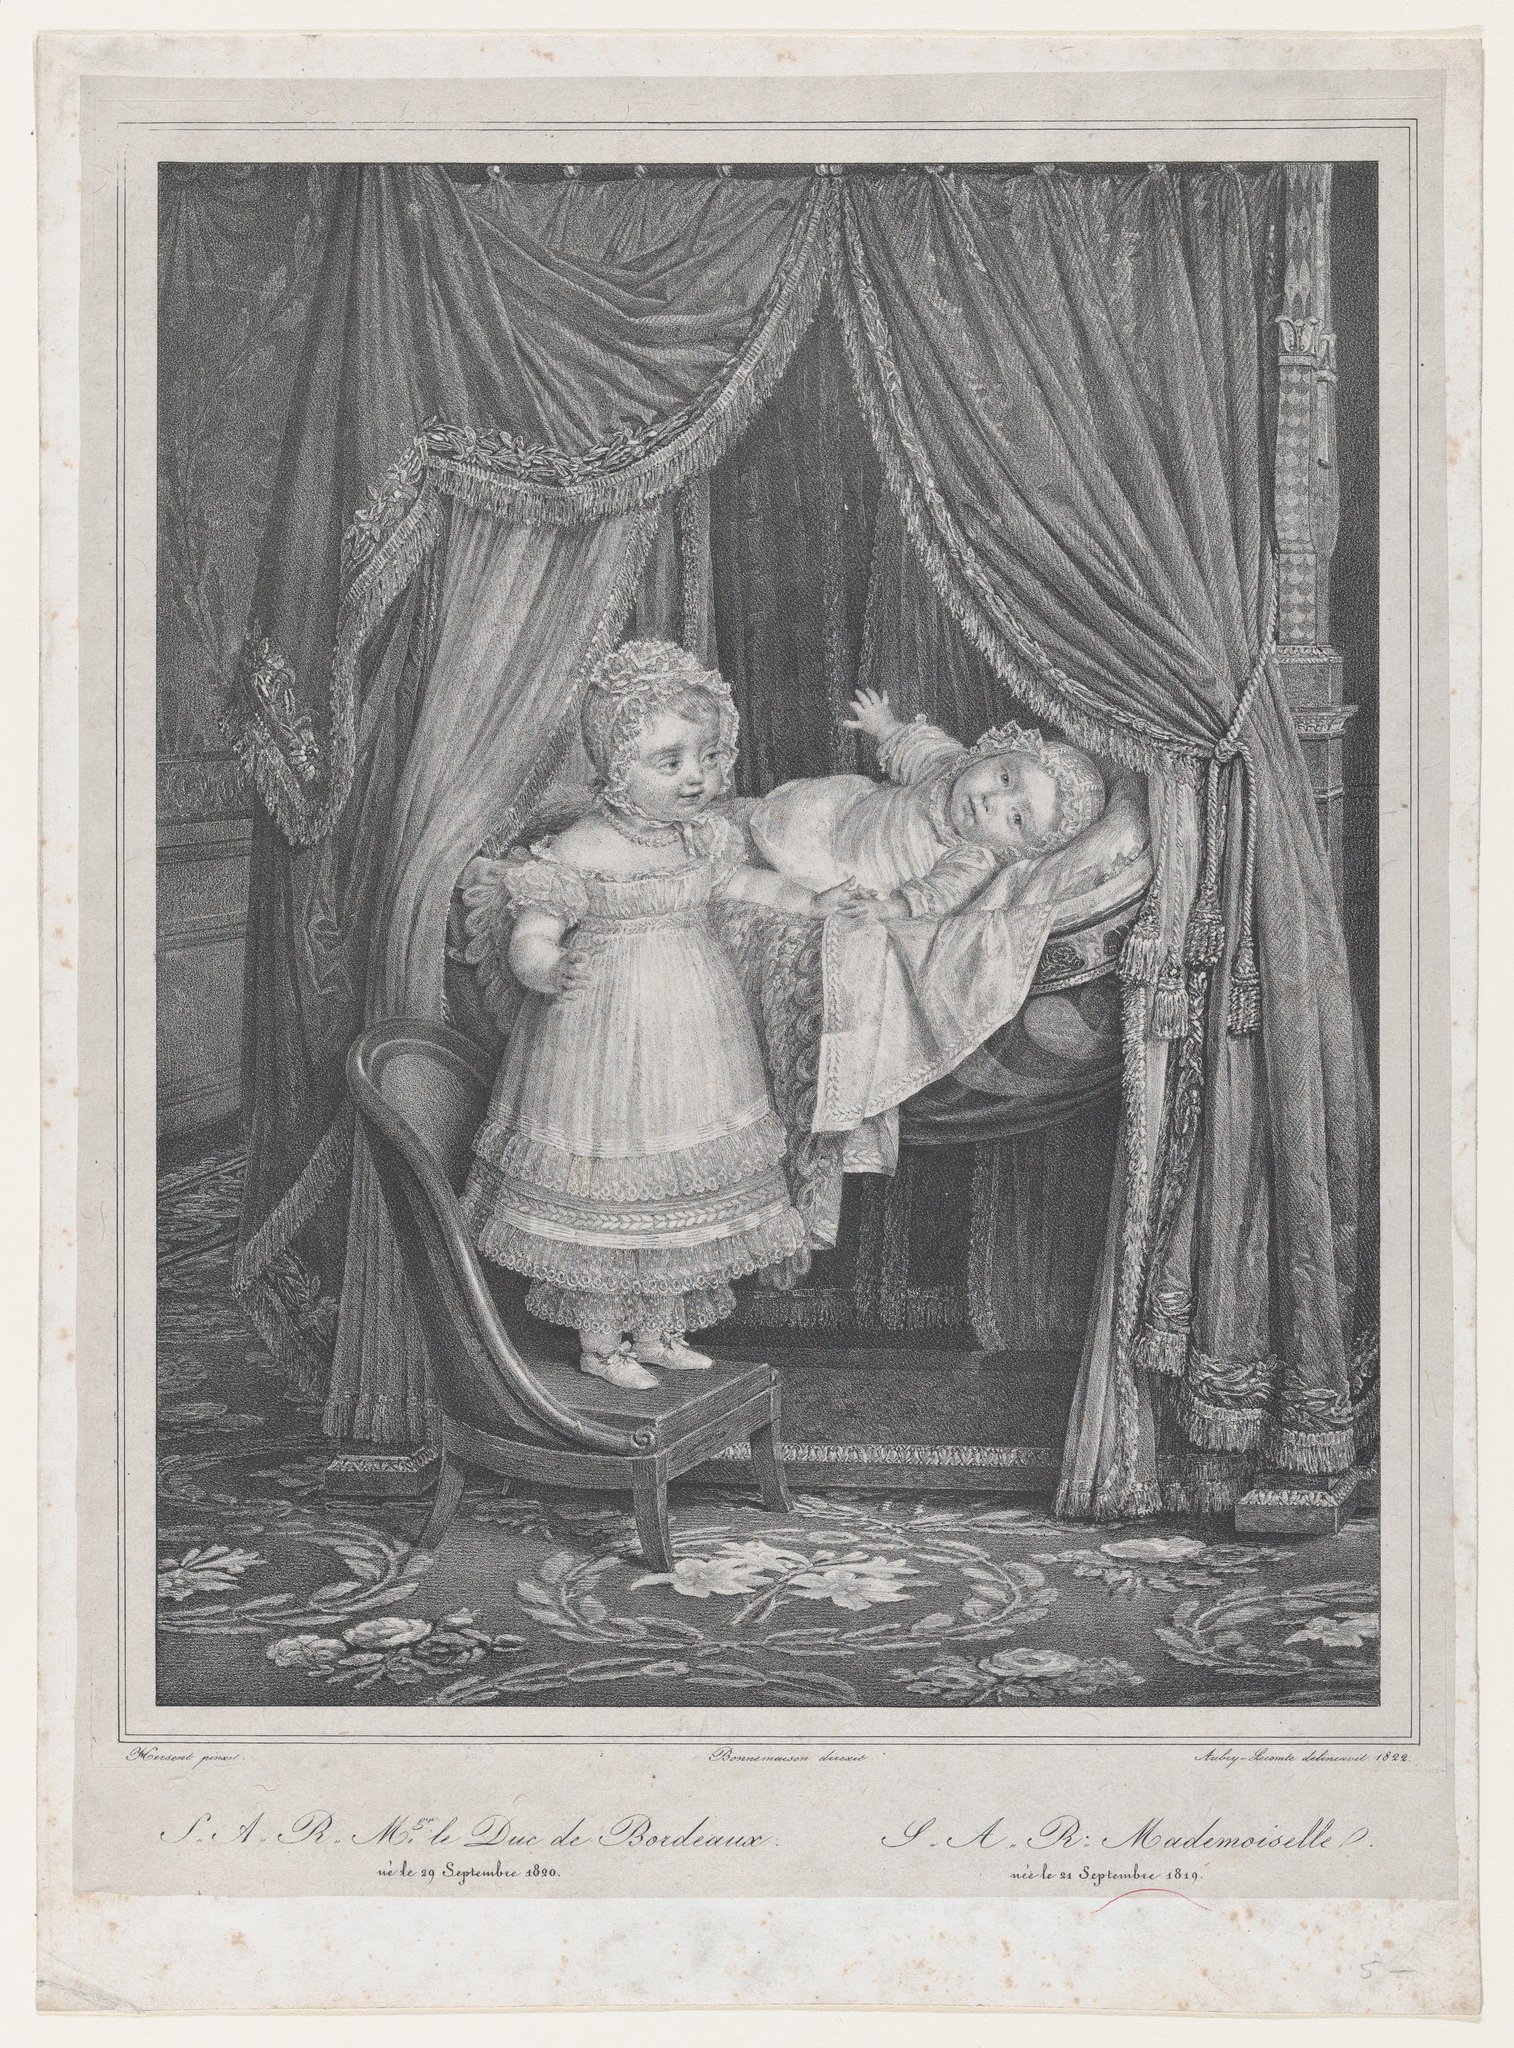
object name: print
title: S.A.R. Mgr le Duc de Bordeaux...S.A.R. Mademoiselle...(Portr. du Comte de Chambord et la duchesse de Parme, enfants)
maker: hyacinthe-louis-victor-jean-baptiste aubry-lecomte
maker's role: artist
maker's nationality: french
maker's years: 1797-1858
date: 1822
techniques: lithograph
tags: children,infants,cradles